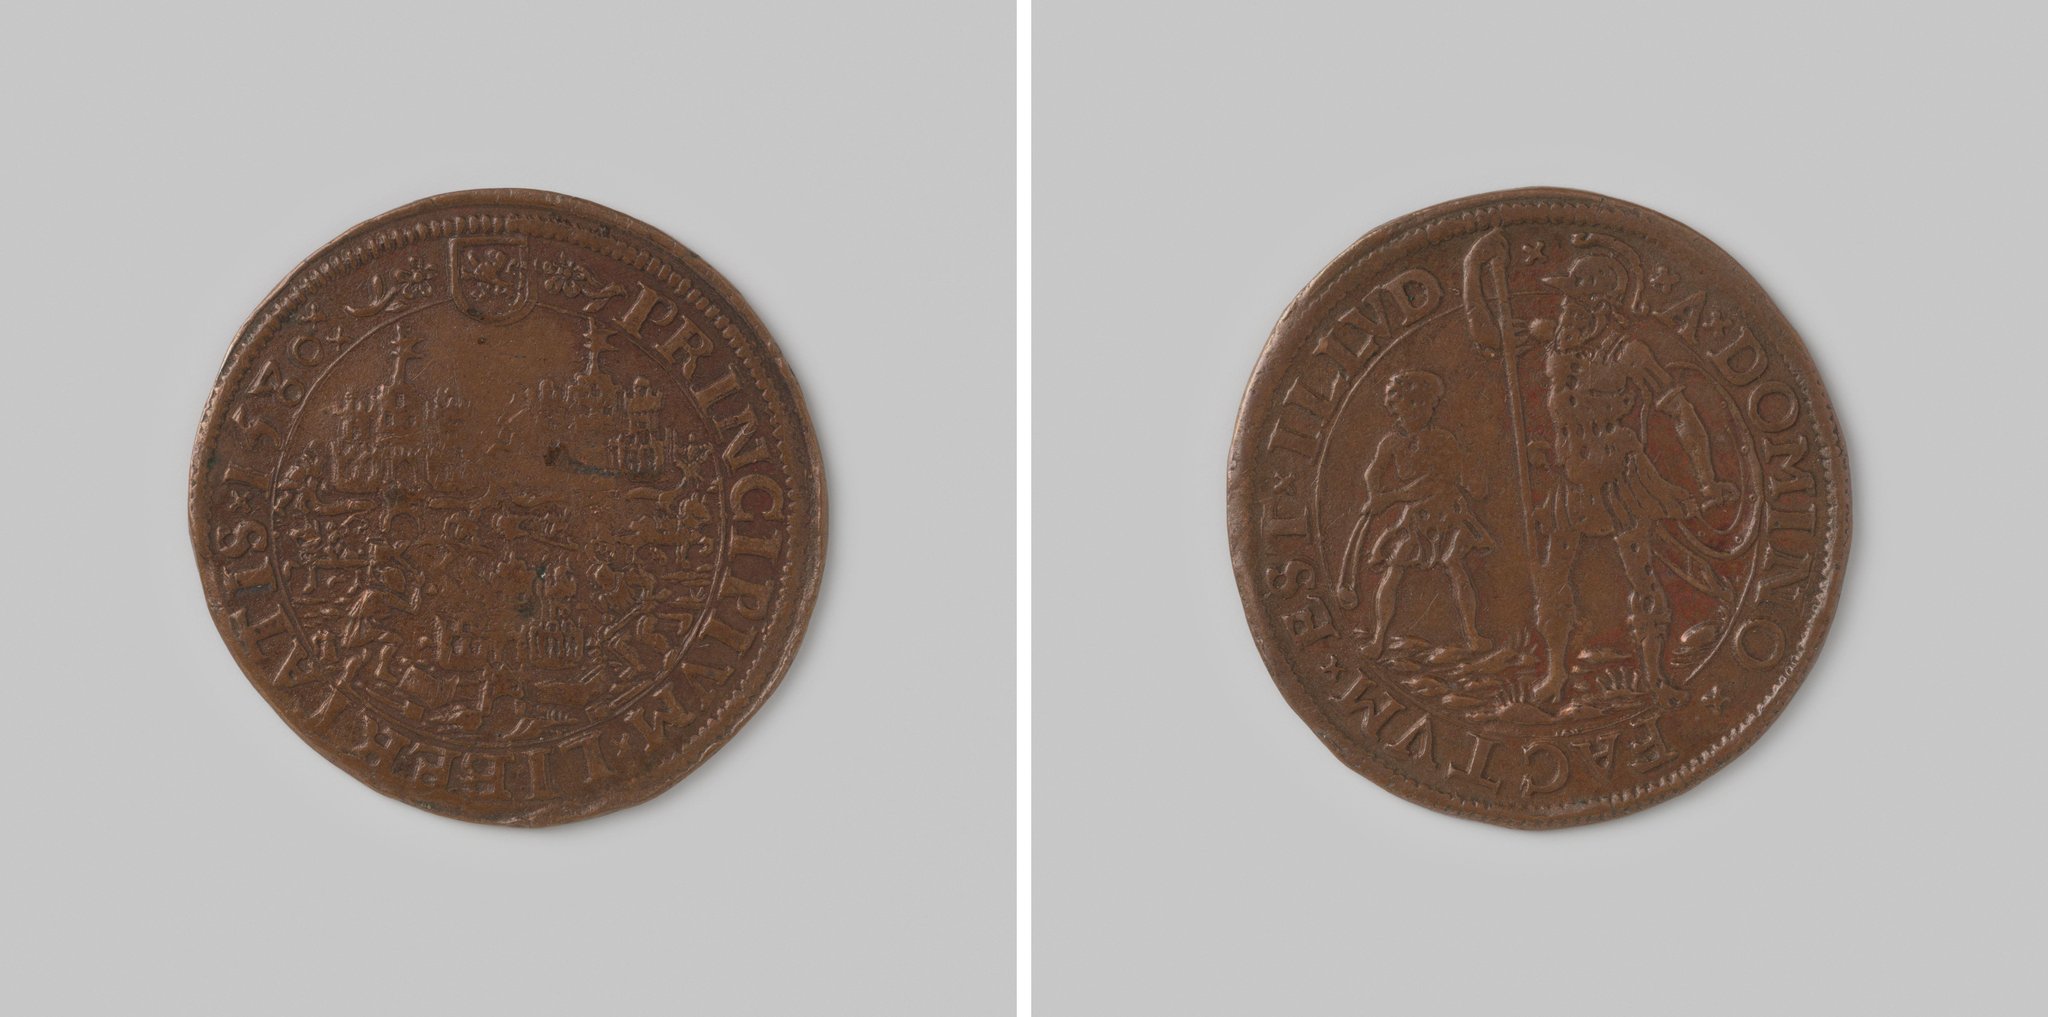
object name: jeton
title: Rekenpenning op het slechten van de forten van Leeuwarden Harlingen en Staveren 1580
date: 1580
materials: copper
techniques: striking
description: Koperen penning, op de voorzijde het afbreken van drie forten, met omschrift, op de keerzijde David en Goliath met omschrift.